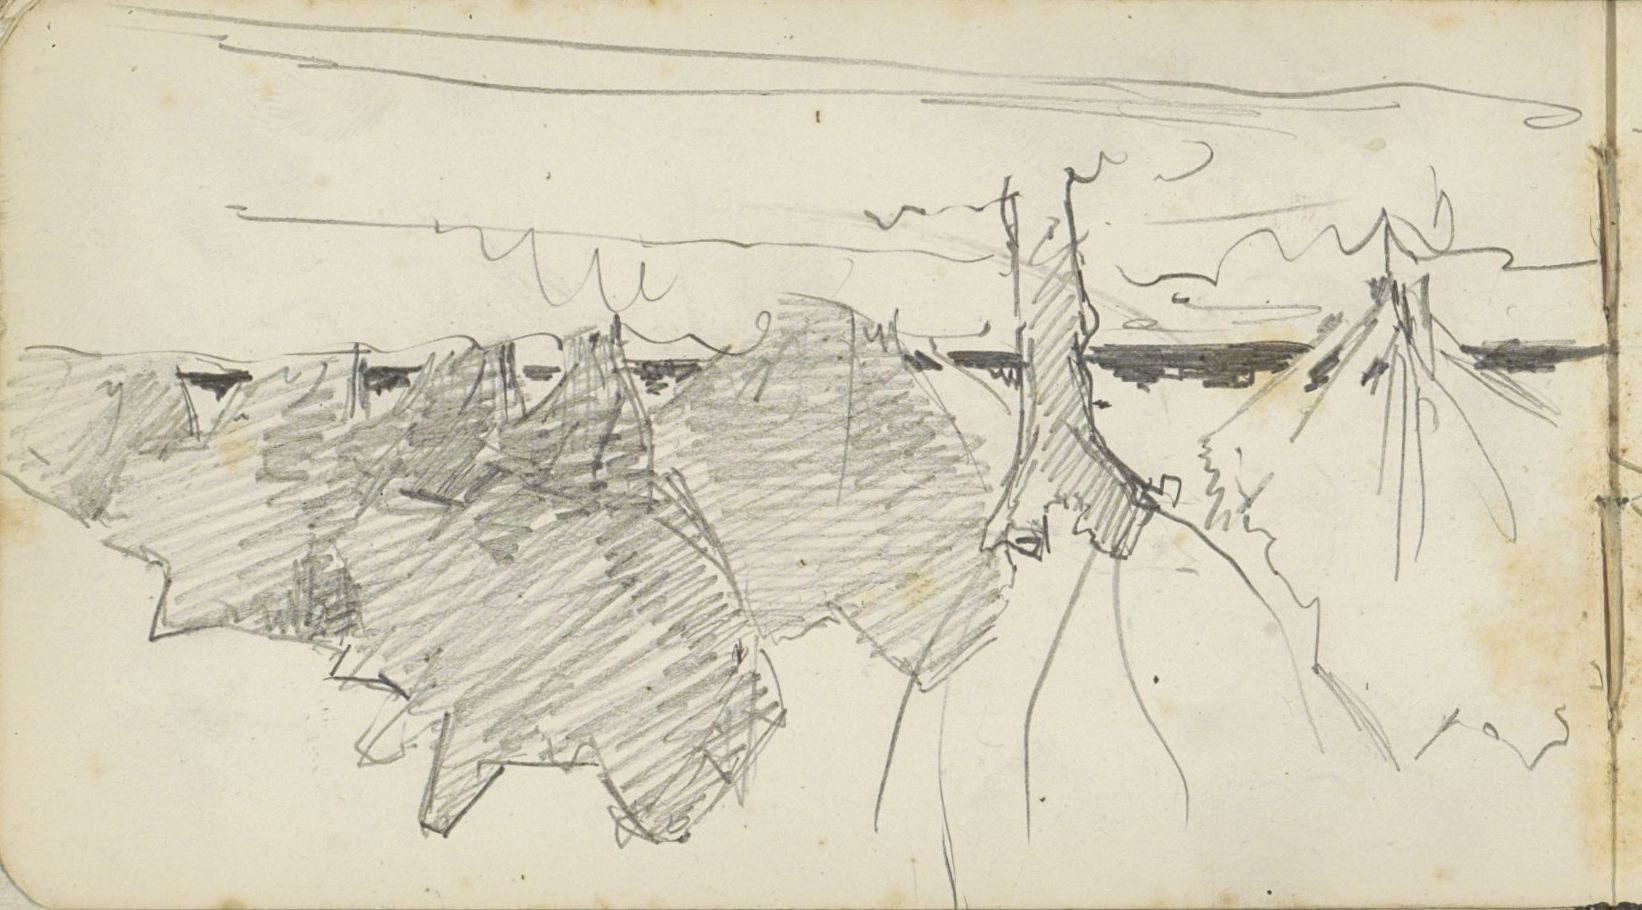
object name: sketchbook leaf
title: Landschap met knotwilgen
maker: geo poggenbeek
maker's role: draughtsman, painter, print maker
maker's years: 1853-1903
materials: paper, pencil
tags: trees: willow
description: Blad 59 verso uit een schetsboek met 69 bladen.